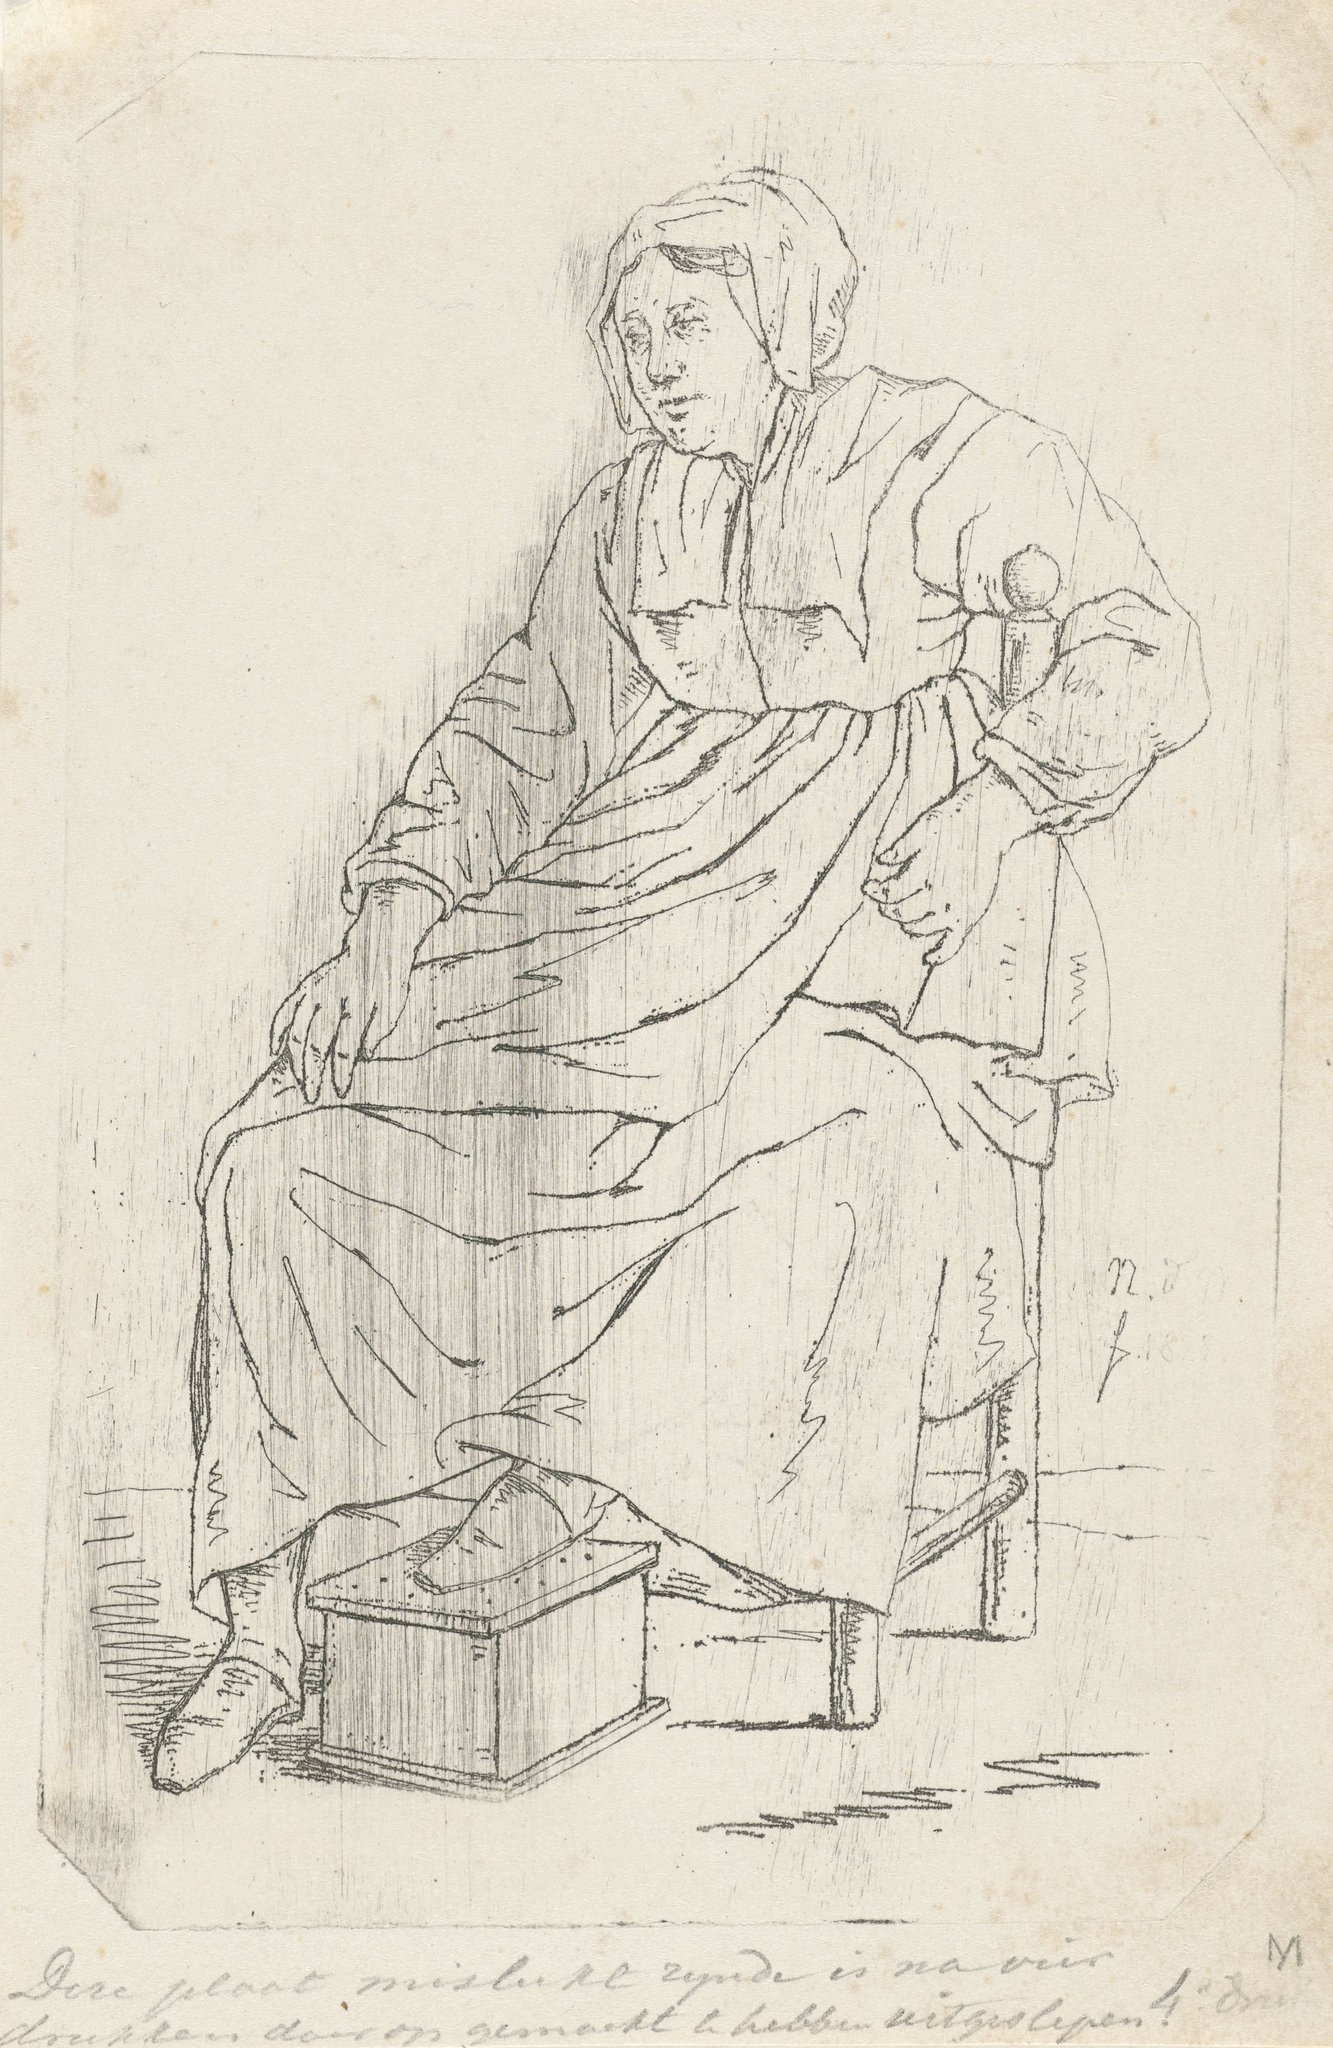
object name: print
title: Zittend vrouw met voet op voetstoof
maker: anthonie willem hendrik nolthenius de man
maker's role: draughtsman, print maker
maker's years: 1793-1842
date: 1828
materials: paper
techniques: etching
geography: nijmegen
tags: sitting figure - aa - female human figure, foot-stove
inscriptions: caption: ‘Deze plaat mislukt zijnde is na vier/ drukken daarop gemaakt te hebben uitgeslepen 4e druk’, collector's mark: Lugt 2228